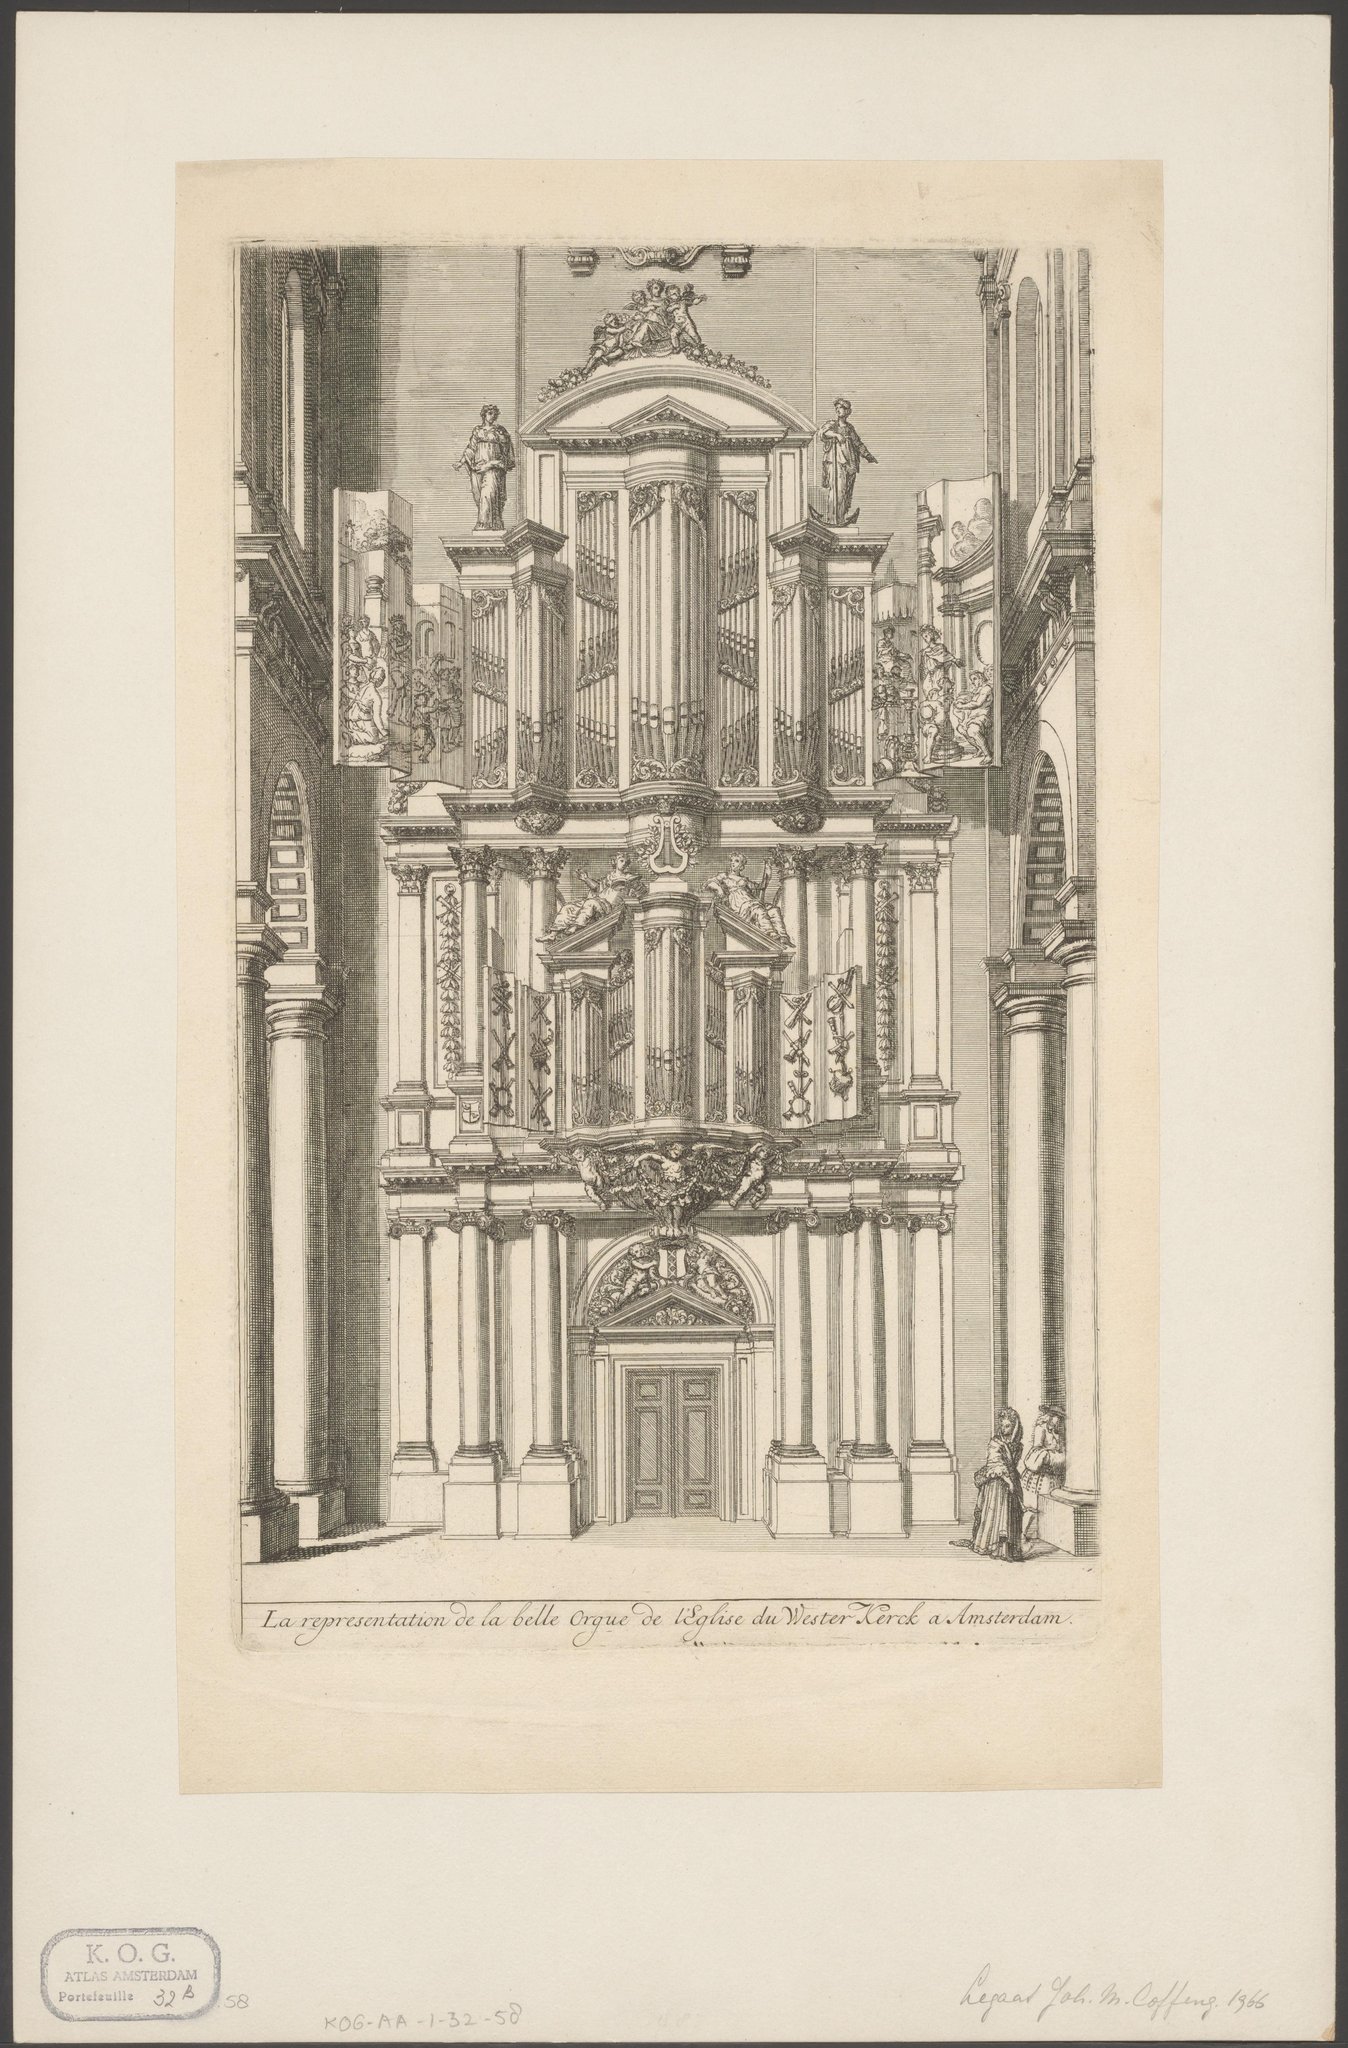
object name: print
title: La representation de la belle Orgue de l'Eglise du Wester Kerck a Amsterdam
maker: Anonymous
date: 1700-1749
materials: paper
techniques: engraving, etching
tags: church organ, interior of church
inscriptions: collector's mark: ‘32B.58’ Lugt 1641b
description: Volgens Stadsarchief door Jan Goeree, maar dit klopt niet. Goeree's prent van het orgel ziet er anders uit en draagt de titel 'Het Orgel in de Wester-Kerke' (in: Jan Wagenaar, Amsterdam, in zyne opkomst, aanwas, geschiedenissen (...), dl. 2, 1765).